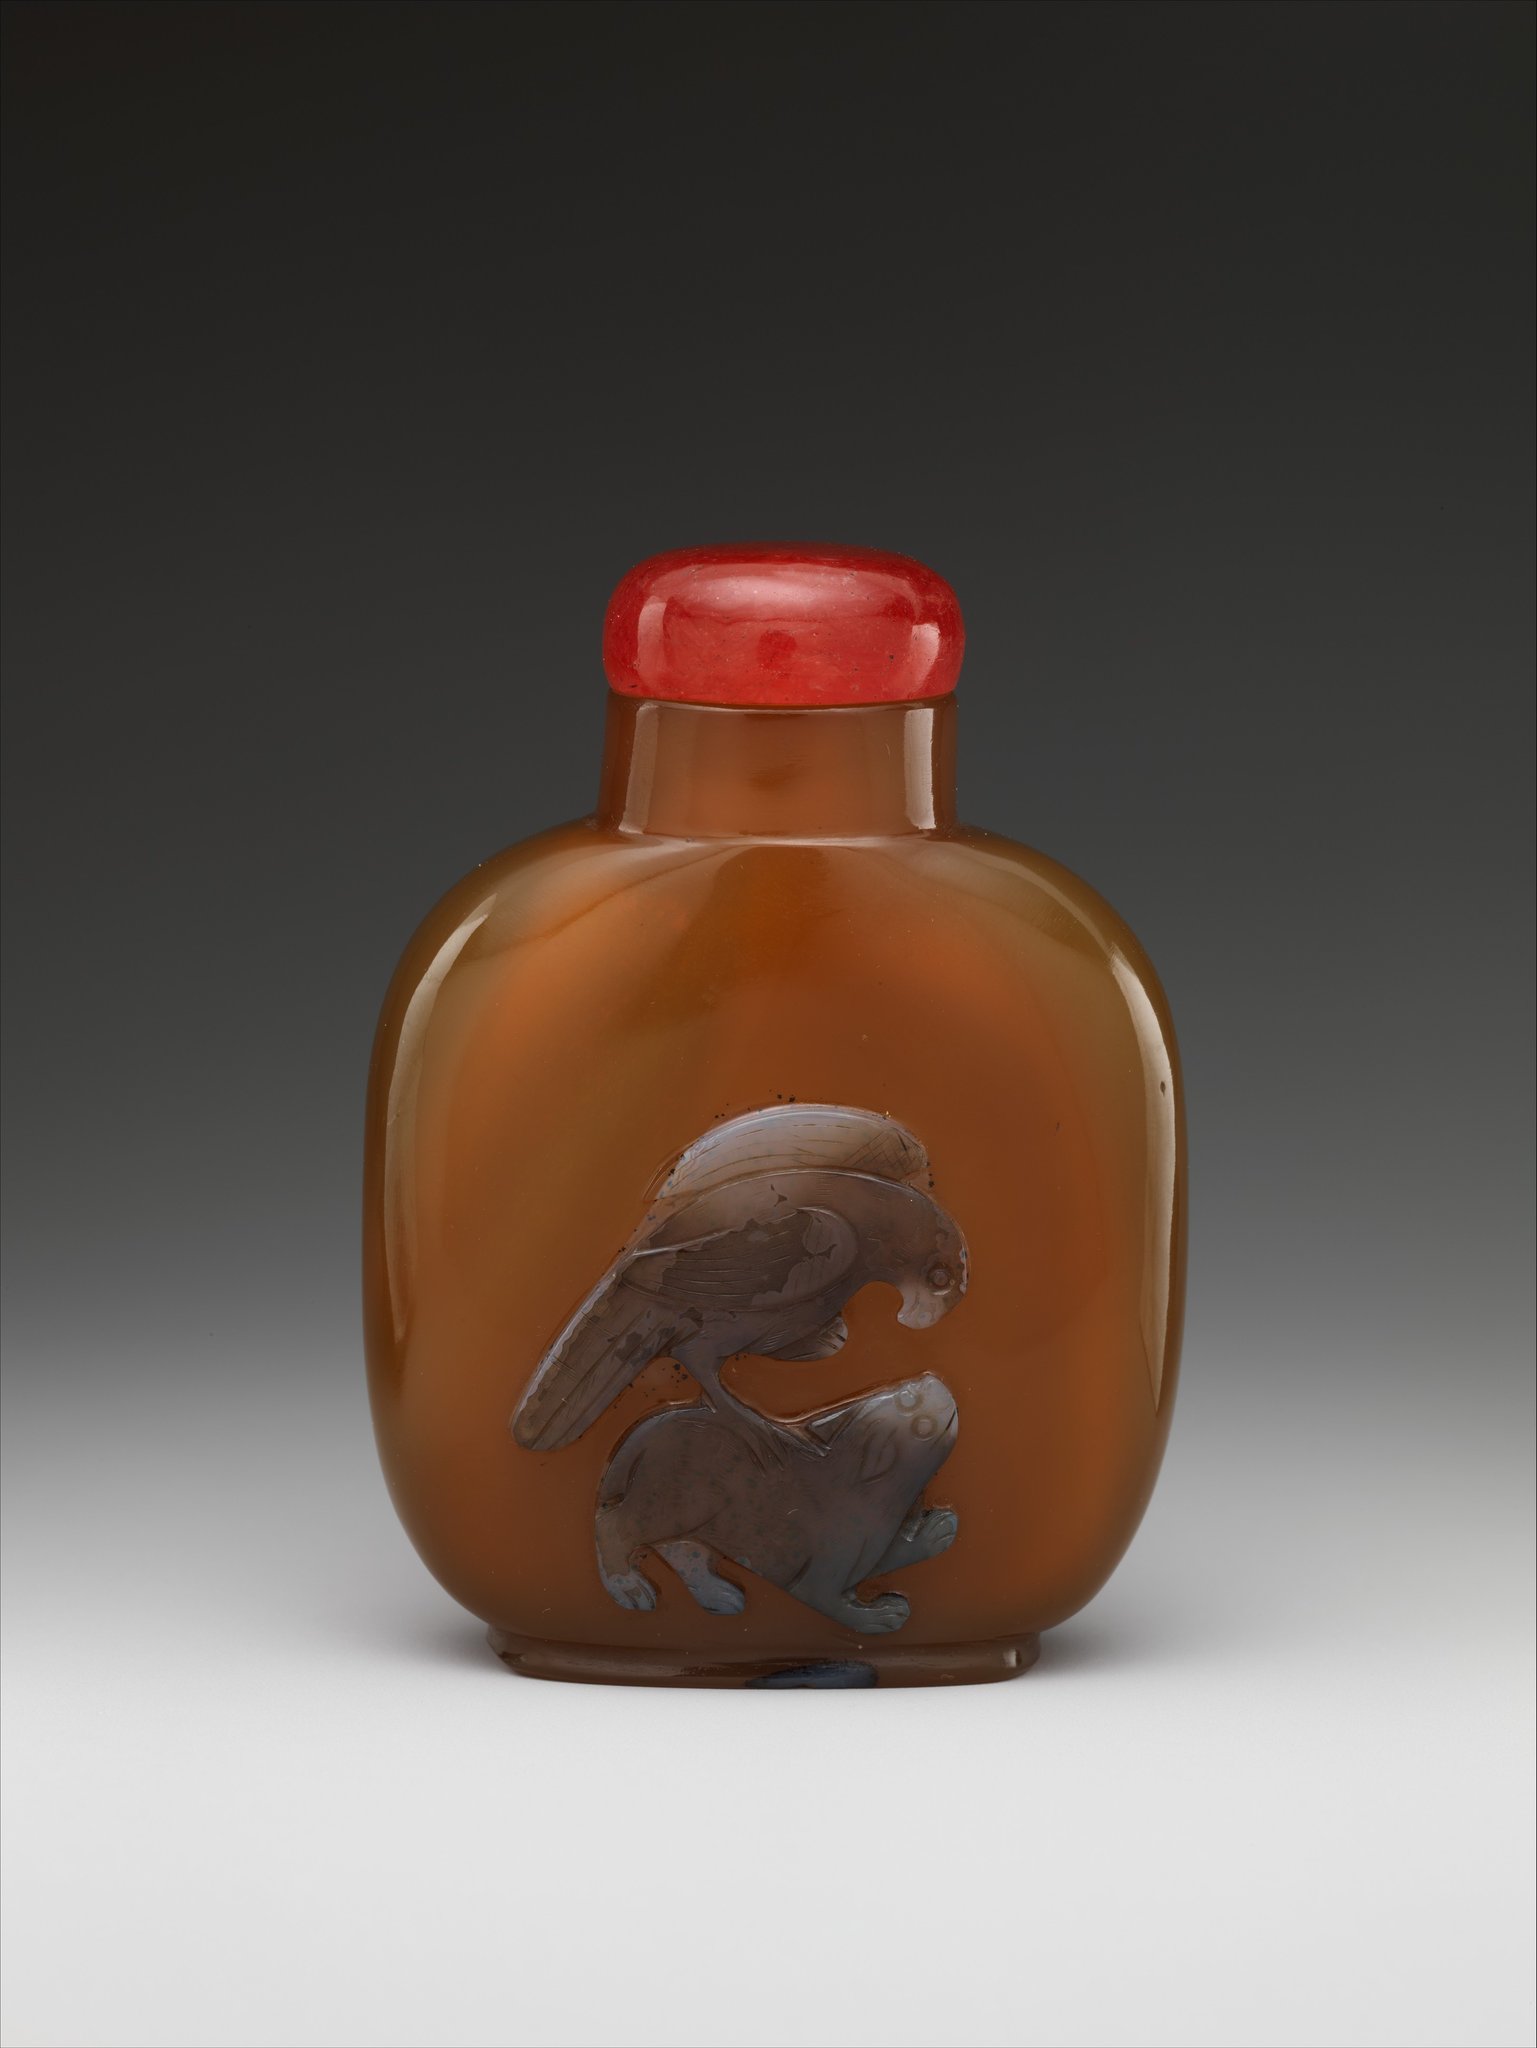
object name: snuff bottle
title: Snuff bottle with eagle and bear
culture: chinese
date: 1801-1900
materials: stone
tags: bears,eagles